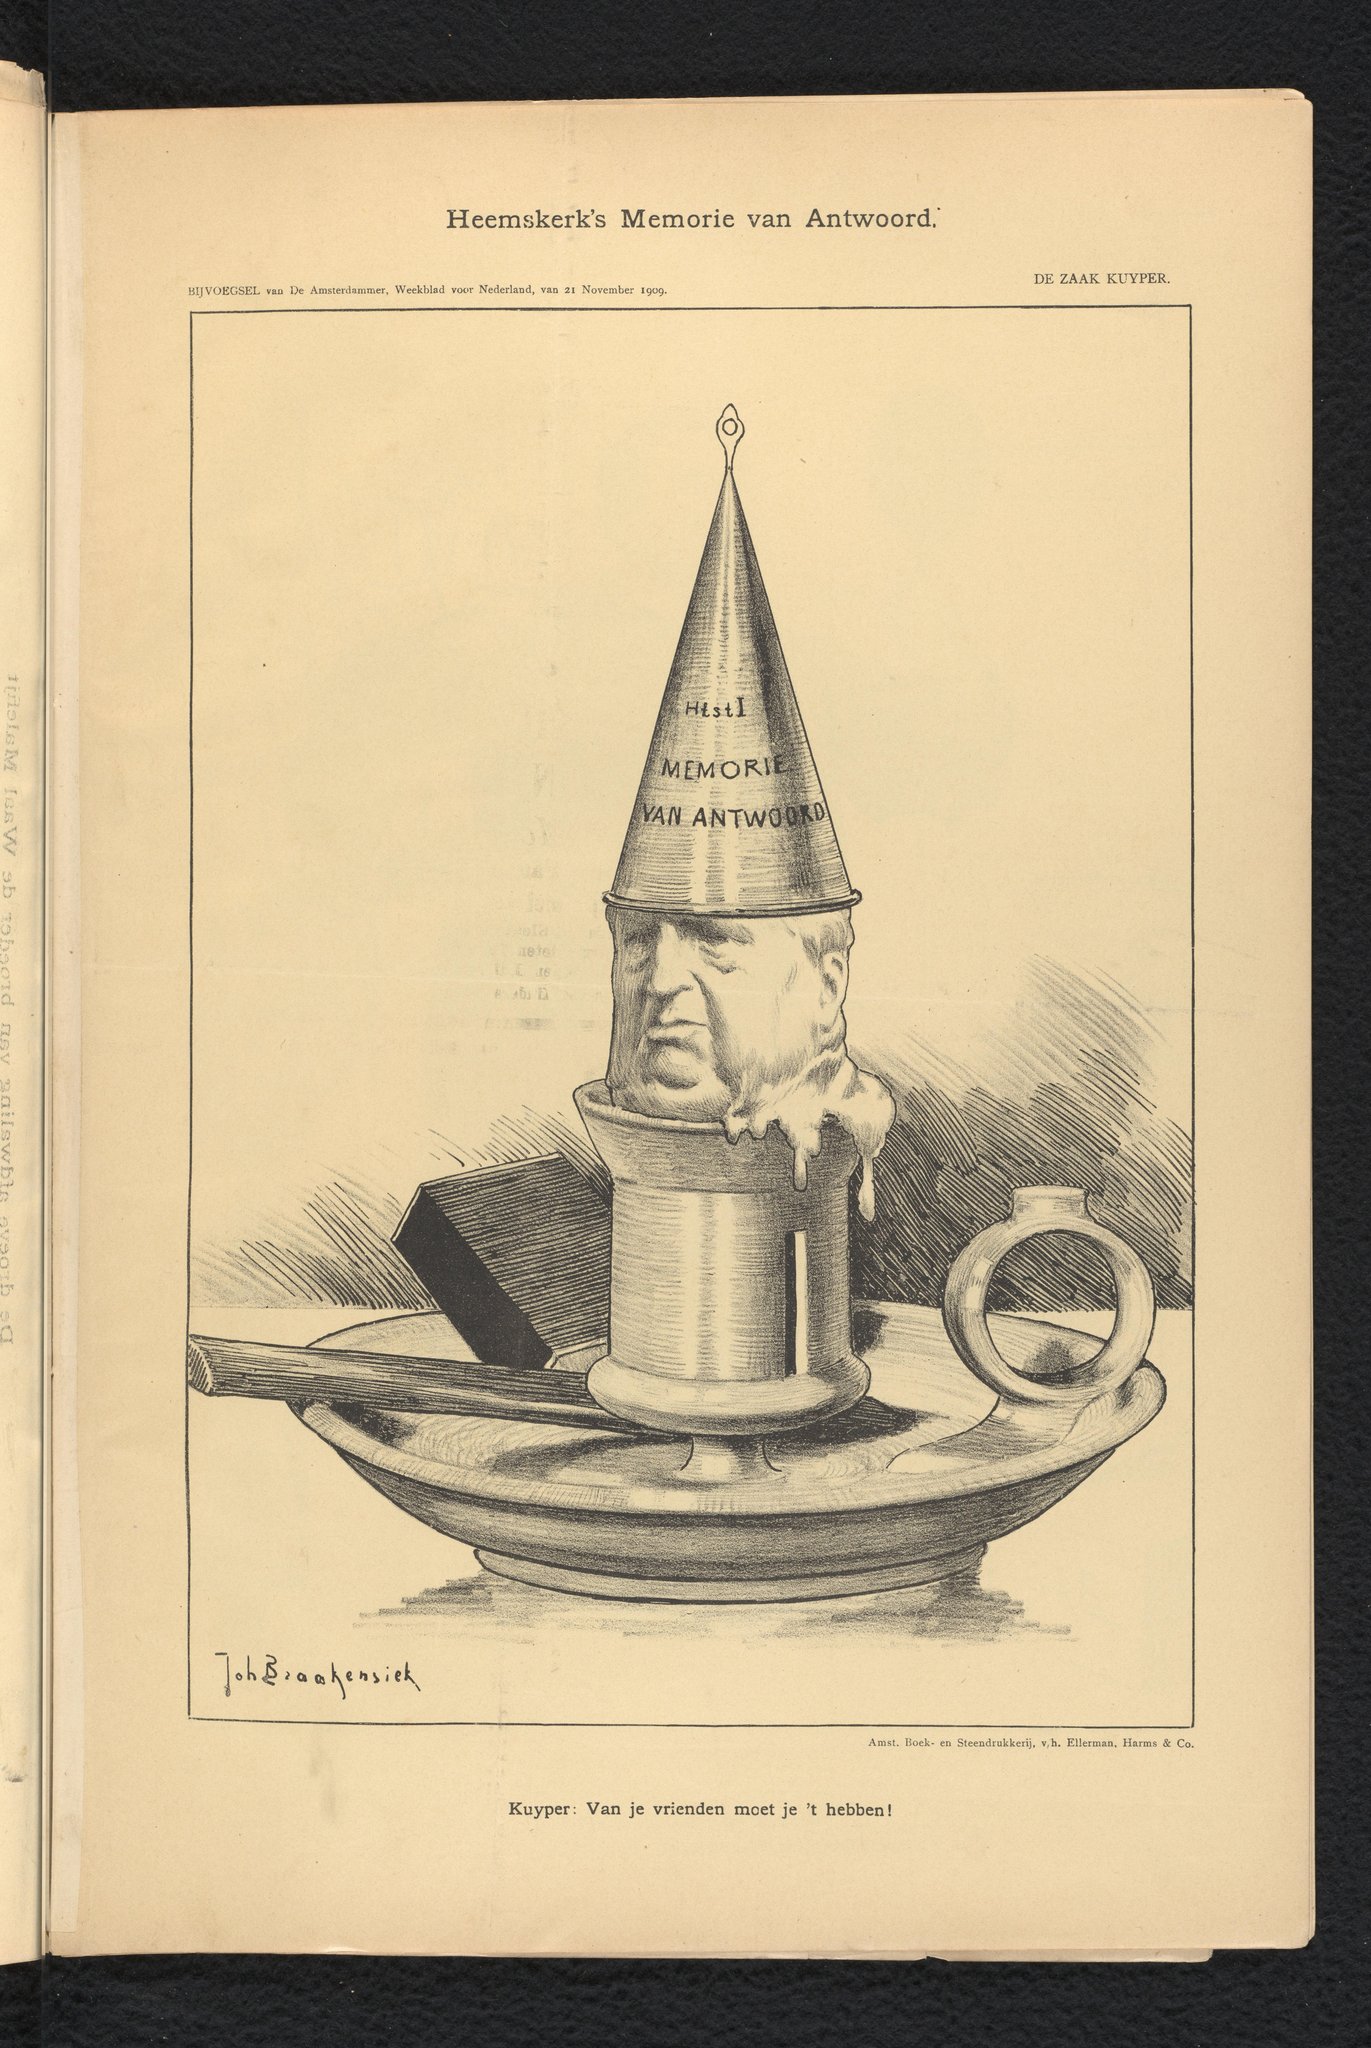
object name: cartoon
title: Heemskerk's Memorie van Antwoord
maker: johan braakensiek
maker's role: draughtsman, print maker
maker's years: 1858-1940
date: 1909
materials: paper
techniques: lithograph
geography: netherlands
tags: the hague, abraham kuyper, amsterdam, utrecht, snuffers, candle, political caricatures and satires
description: Abraham Kuyper als een kaars uitgedoofd door de Heemskerk's Memorie van Antwoord.